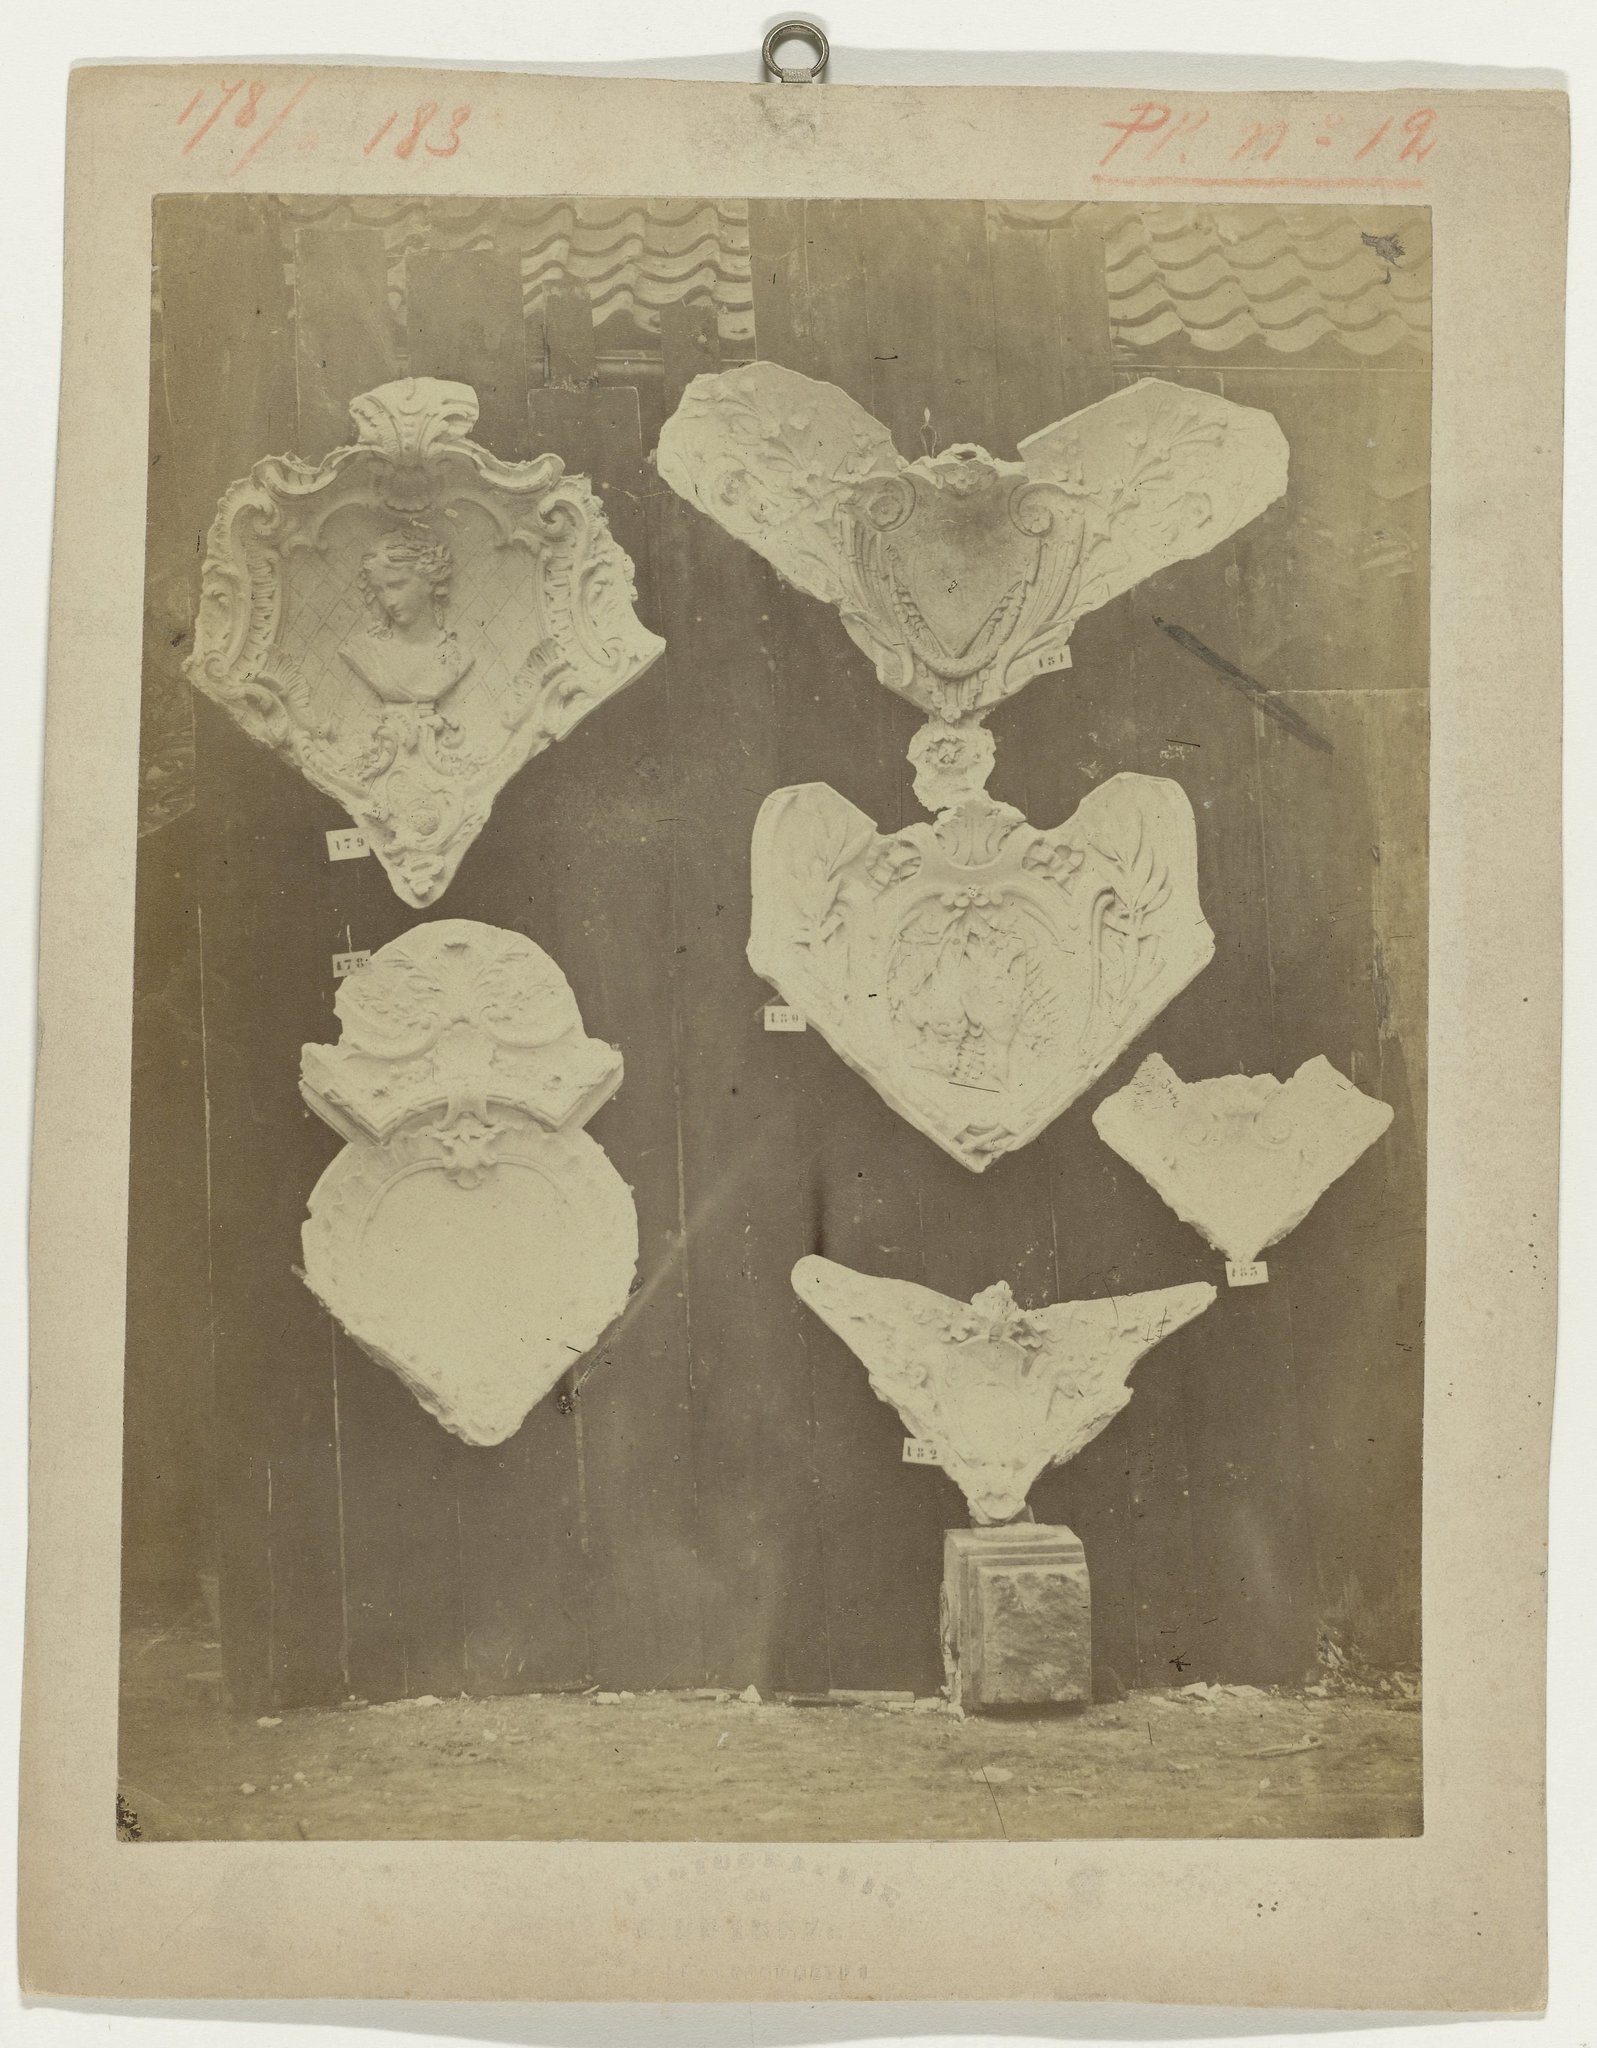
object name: photograph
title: Compositie van gipsen ornamenten uit het atelier van J. Delbove, Brussel, België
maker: charles de trez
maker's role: painter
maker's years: 1822-1899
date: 1860-1882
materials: cardboard, paper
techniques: albumen print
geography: brussels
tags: piece of sculpture, reproduction of a piece of sculpture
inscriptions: inscription: ‘178 à 183 PP. No. 12’, number, inscription, check stamp: ‘PHOTOGRAPHIE/ DE/ C. DE TREZ &/ RUE DU PONT NEUF 1’, check stamp: ‘J.H DELBOVE/ Rue de Malines, 37/ BRUXELLES’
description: Foto uit een incomplete serie van 13 foto's. Foto heeft sporen van een oogje aan de bovenzijde waaruit blijkt dat de foto gehangen heeft. Recto zijn nummers per voorwerp meegefotografeerd, corresponderend met een handgeschreven lijst die verso is geplakt.